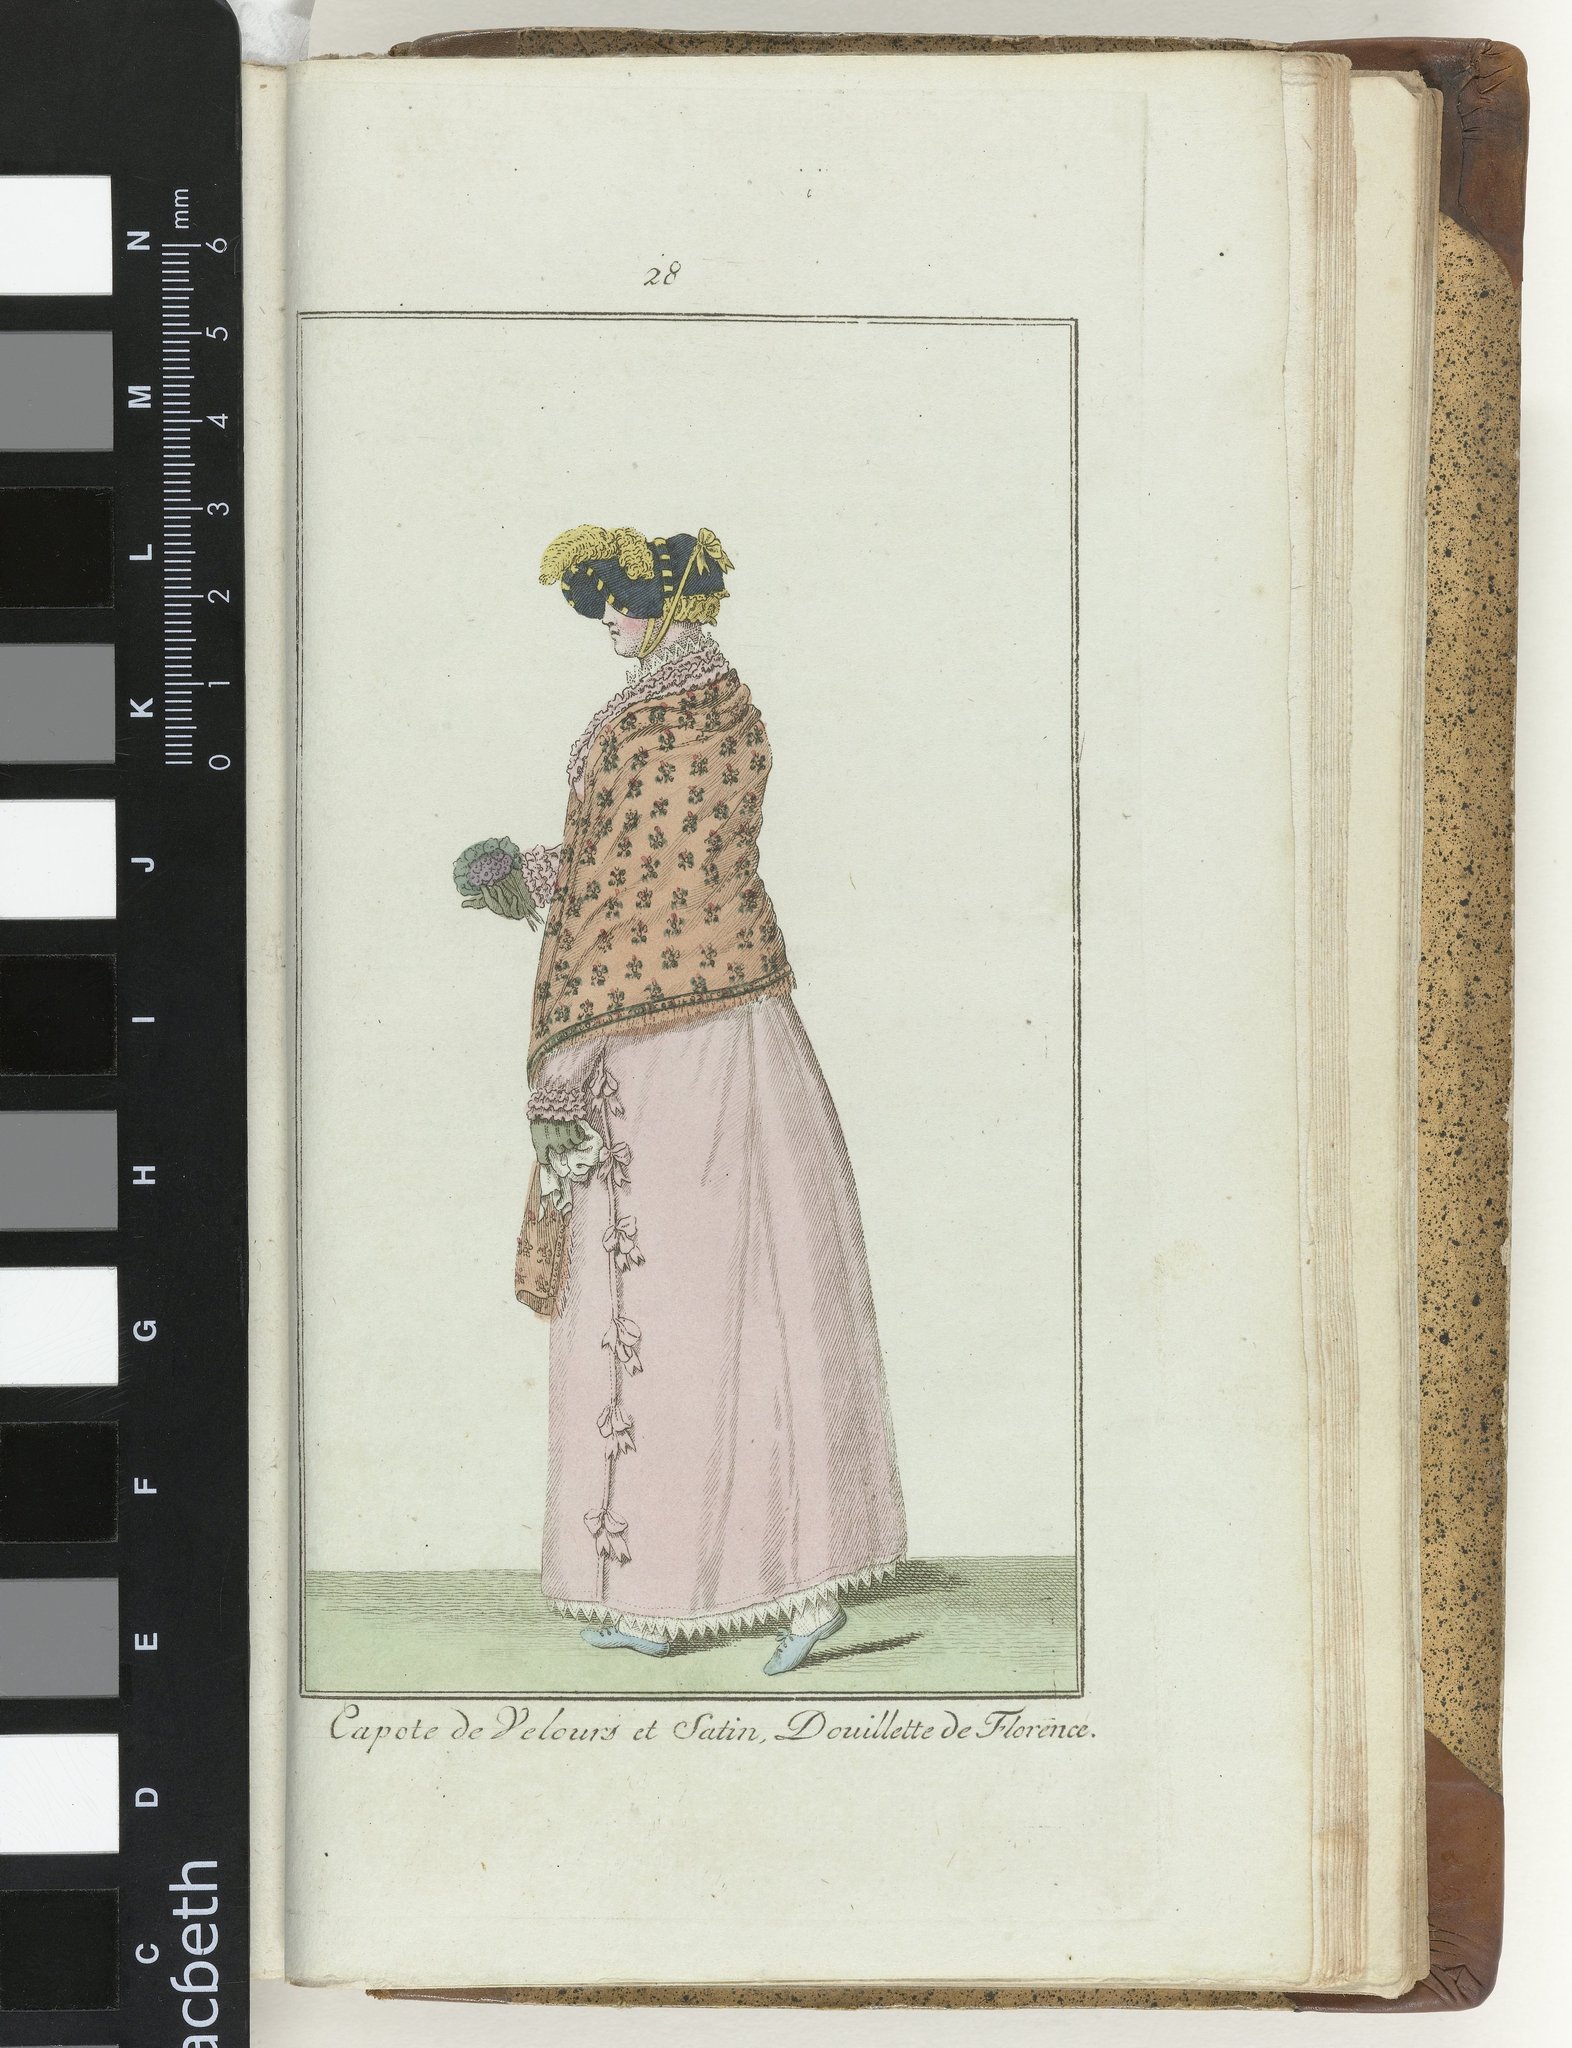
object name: magazine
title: Elegantia, of tijdschrift van mode, luxe en smaak voor dames, November 1807, No. 28: Capote de Velours et Satin...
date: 1807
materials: paper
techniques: engraving, hand coloring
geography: amsterdam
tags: handkerchief (+ women's clothes), cut flowers; nosegay, bunch of flowers, head-gear (capote) (+ women's clothes), border, ribbon, braid (+ women's clothes), fashion plates, shoes, sandals (+ women's clothes), piece of clothing covering the breast or décolleté (fichu) (+ women's clothes)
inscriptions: caption: ‘Capote de Velours et Satin. Douillette de Florence.’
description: Volgens de begeleidende tekst (p. 360): Rozerode 'douillette de Florence'. Fichu van kasjmier. 'Capote' van donkerblauw satijn en fluweel met gele pluimen en linten. Prent uit het modetijdschrift Elegantia, of tijdschrift van mode, luxe en smaak voor dames 1807-1814 (onderbroken door de periode 1811-1813).